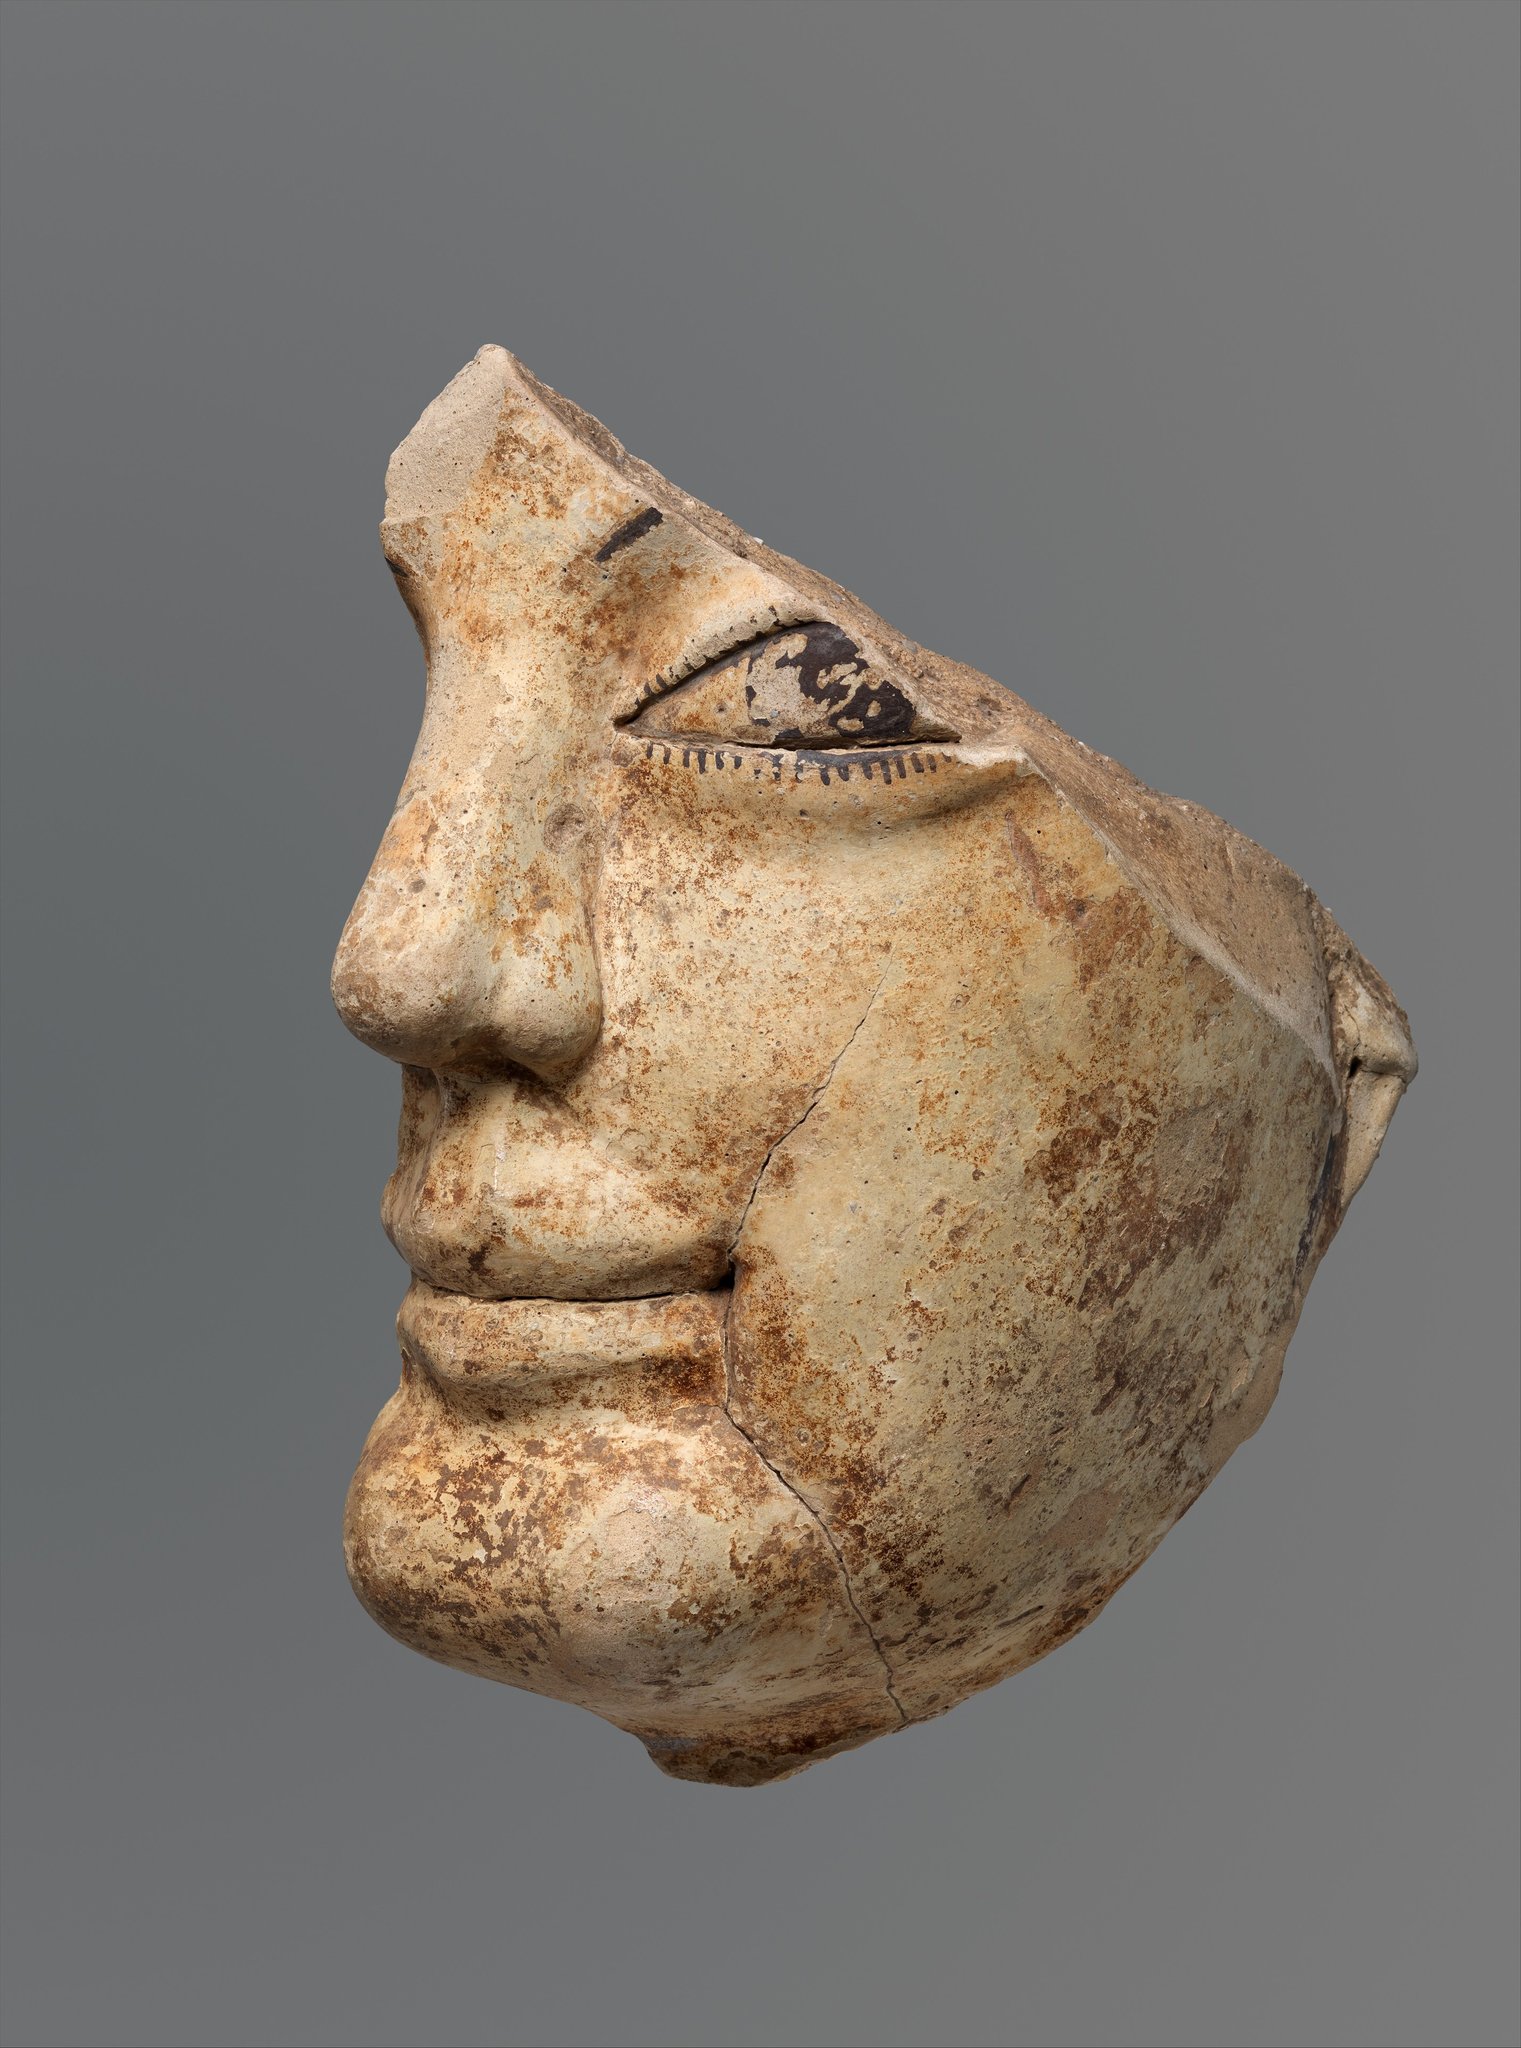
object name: statue head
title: Terracotta head from a statue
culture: greek or south italian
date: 525-500 BCE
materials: terracotta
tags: heads